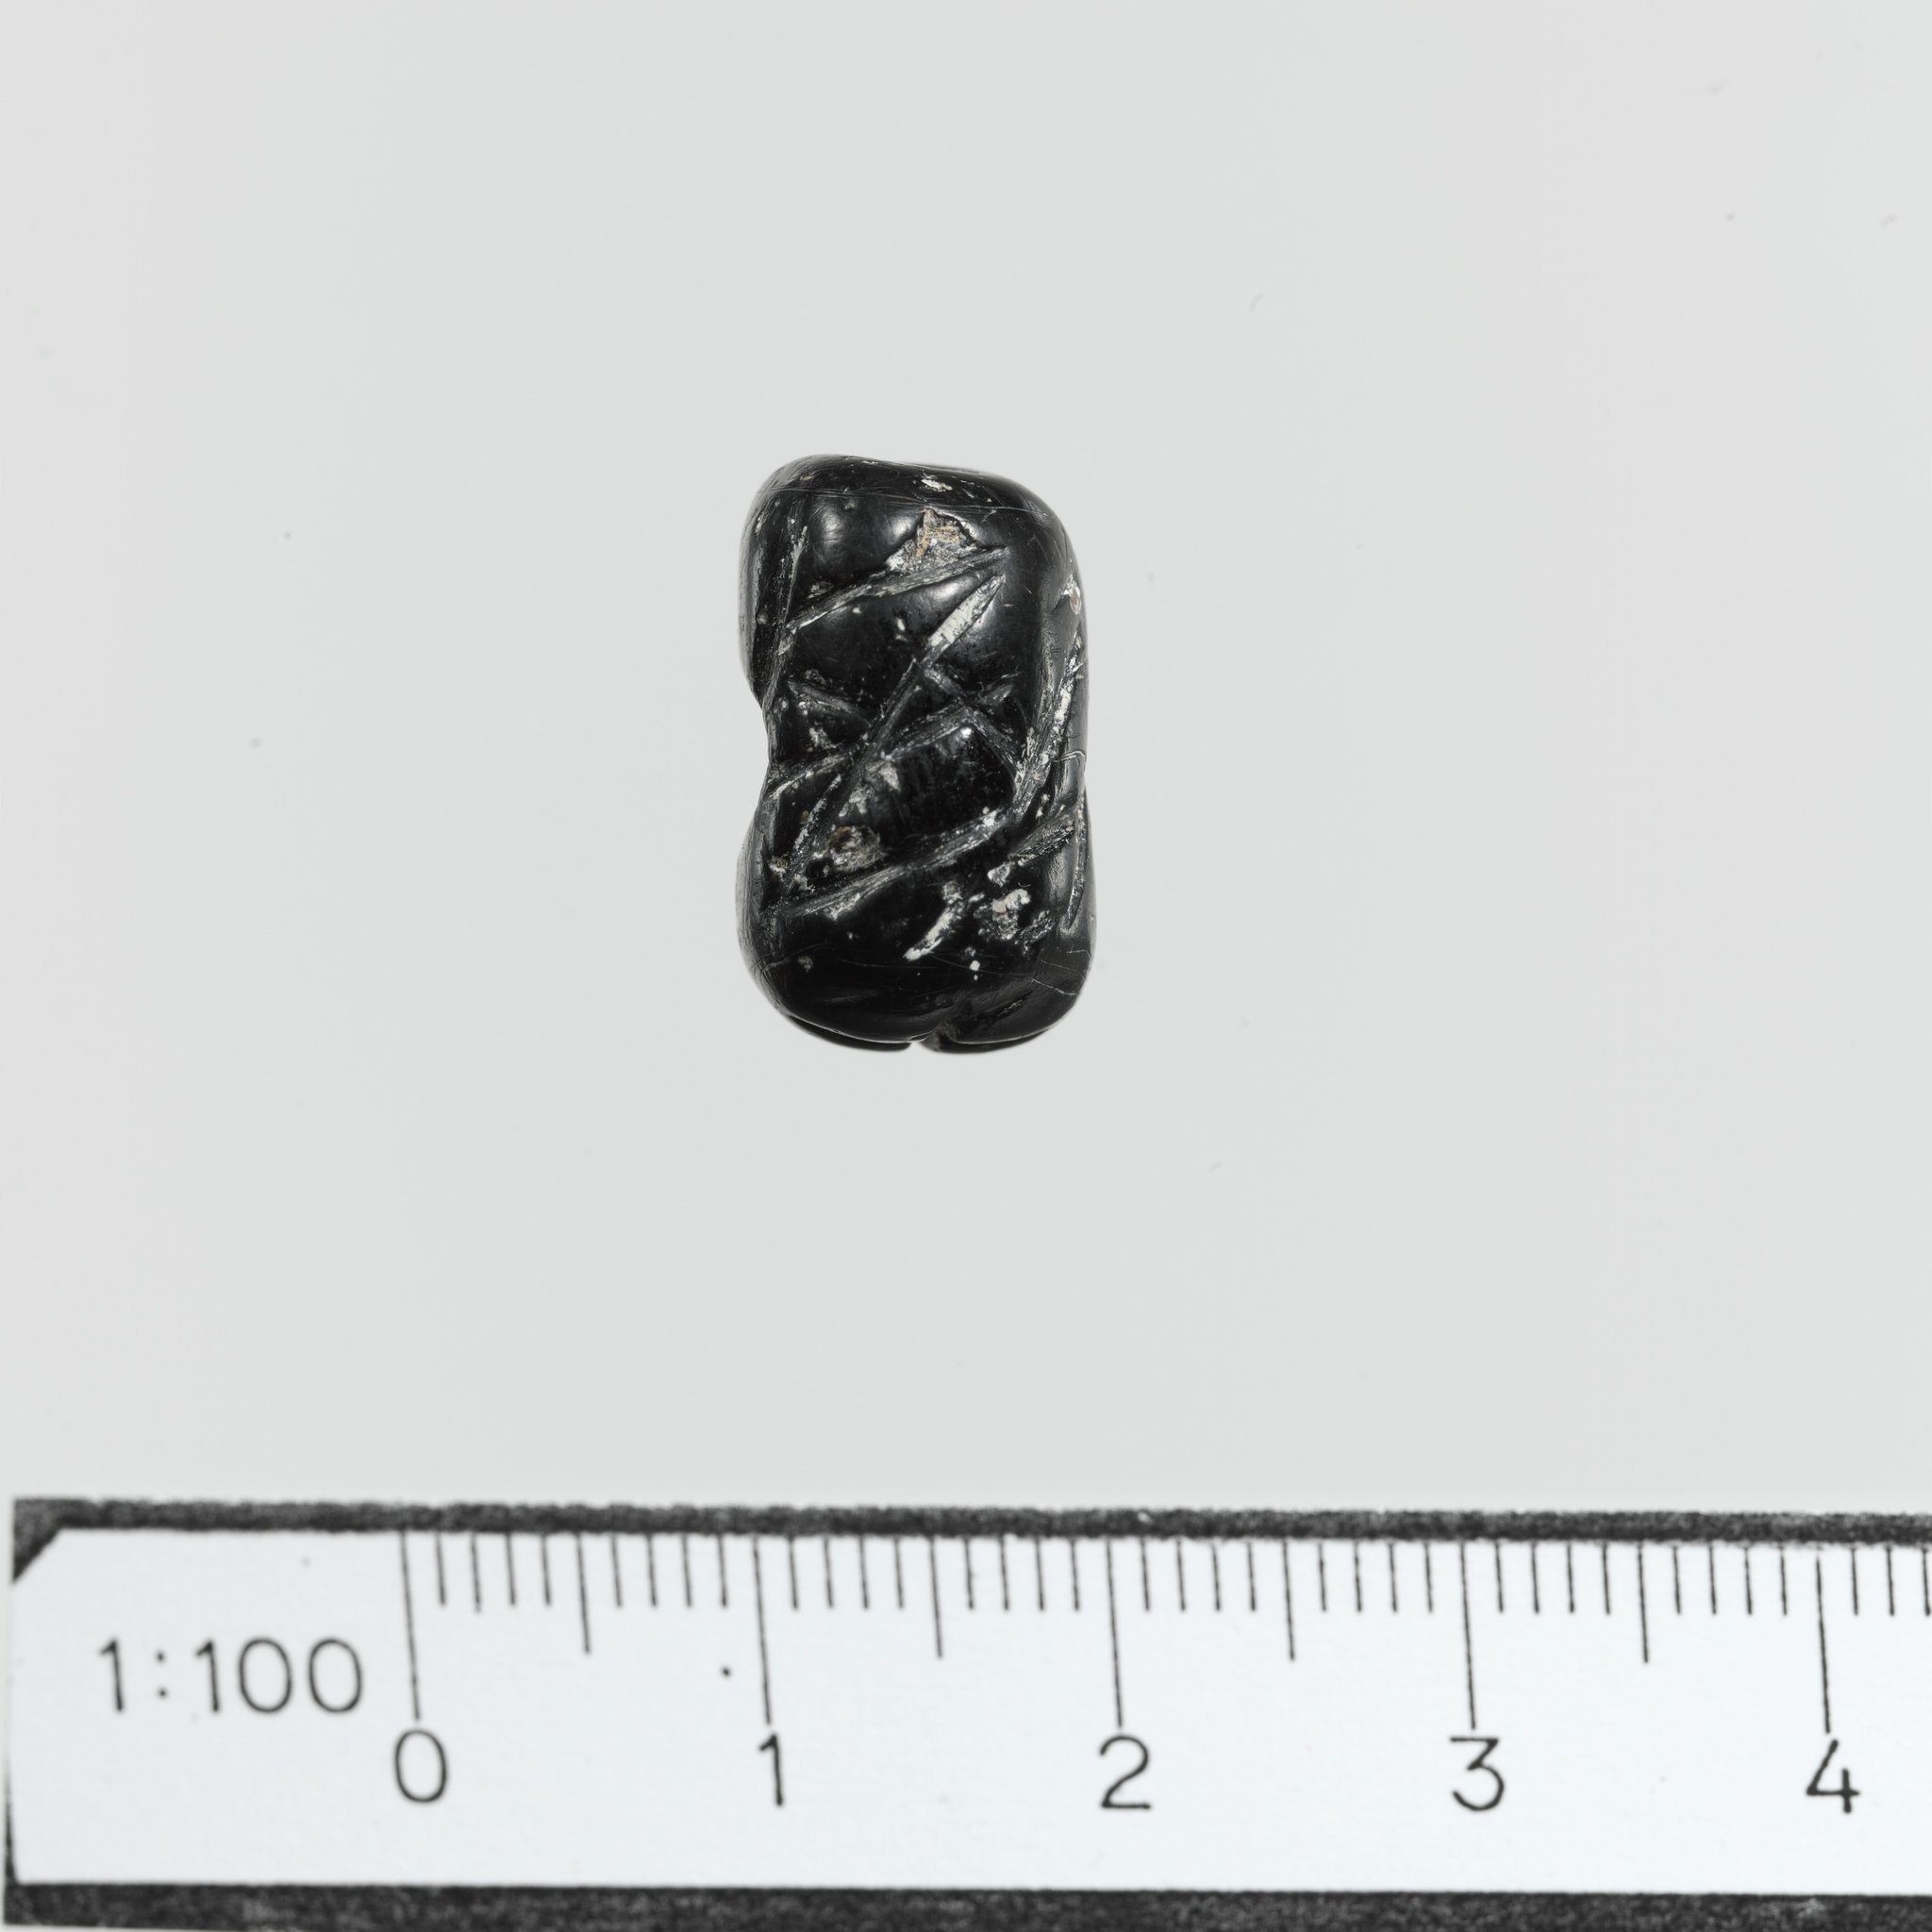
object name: seal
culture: minoan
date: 2600-2000 BCE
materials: stone